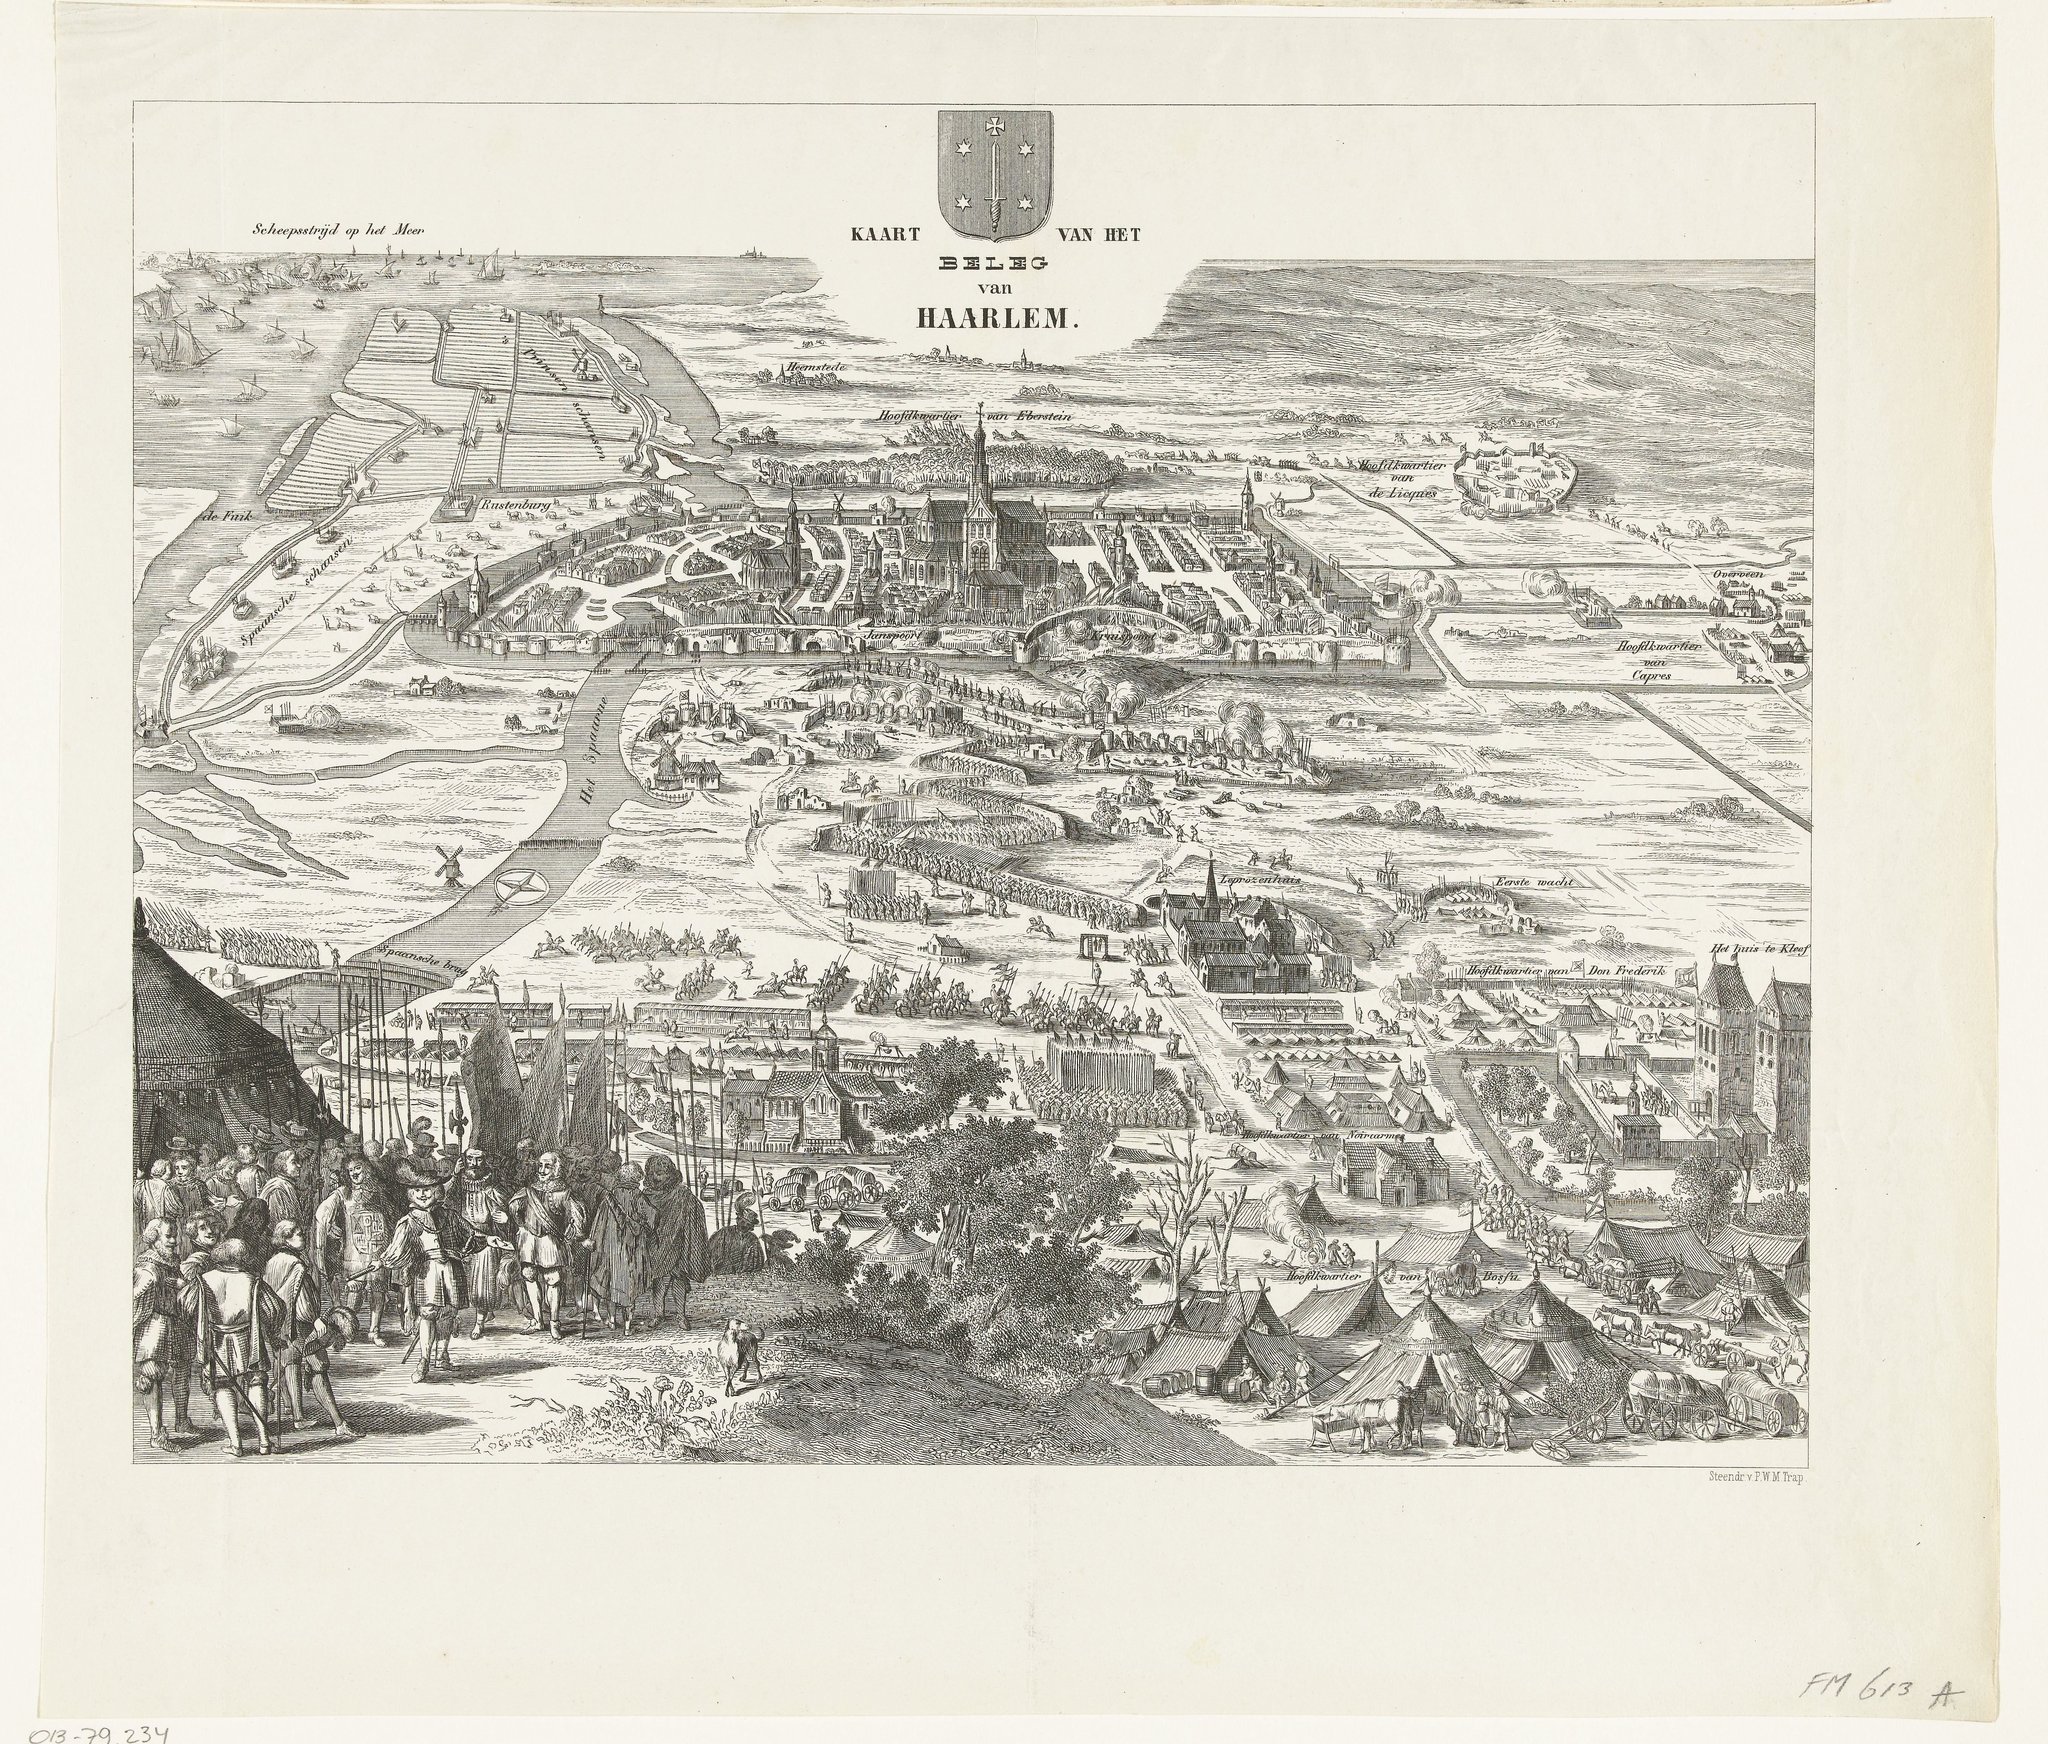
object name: history print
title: Kaart van het Beleg van Haarlem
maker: pieter willem marinus trap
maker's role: print maker, printer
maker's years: 1821-1905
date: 1849-1851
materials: paper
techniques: lithograph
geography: leiden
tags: siege, position war, haarlem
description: Overzicht van het beleg van de stad Haarlem met het omringende gebied in vogelvluchtperspectief. Op de voorgrond links Spaanse officieren bij de legerplaats van de Spaanse troepen, rechts het Huis ter Kleef. Bovenaan het wapen van Haarlem.